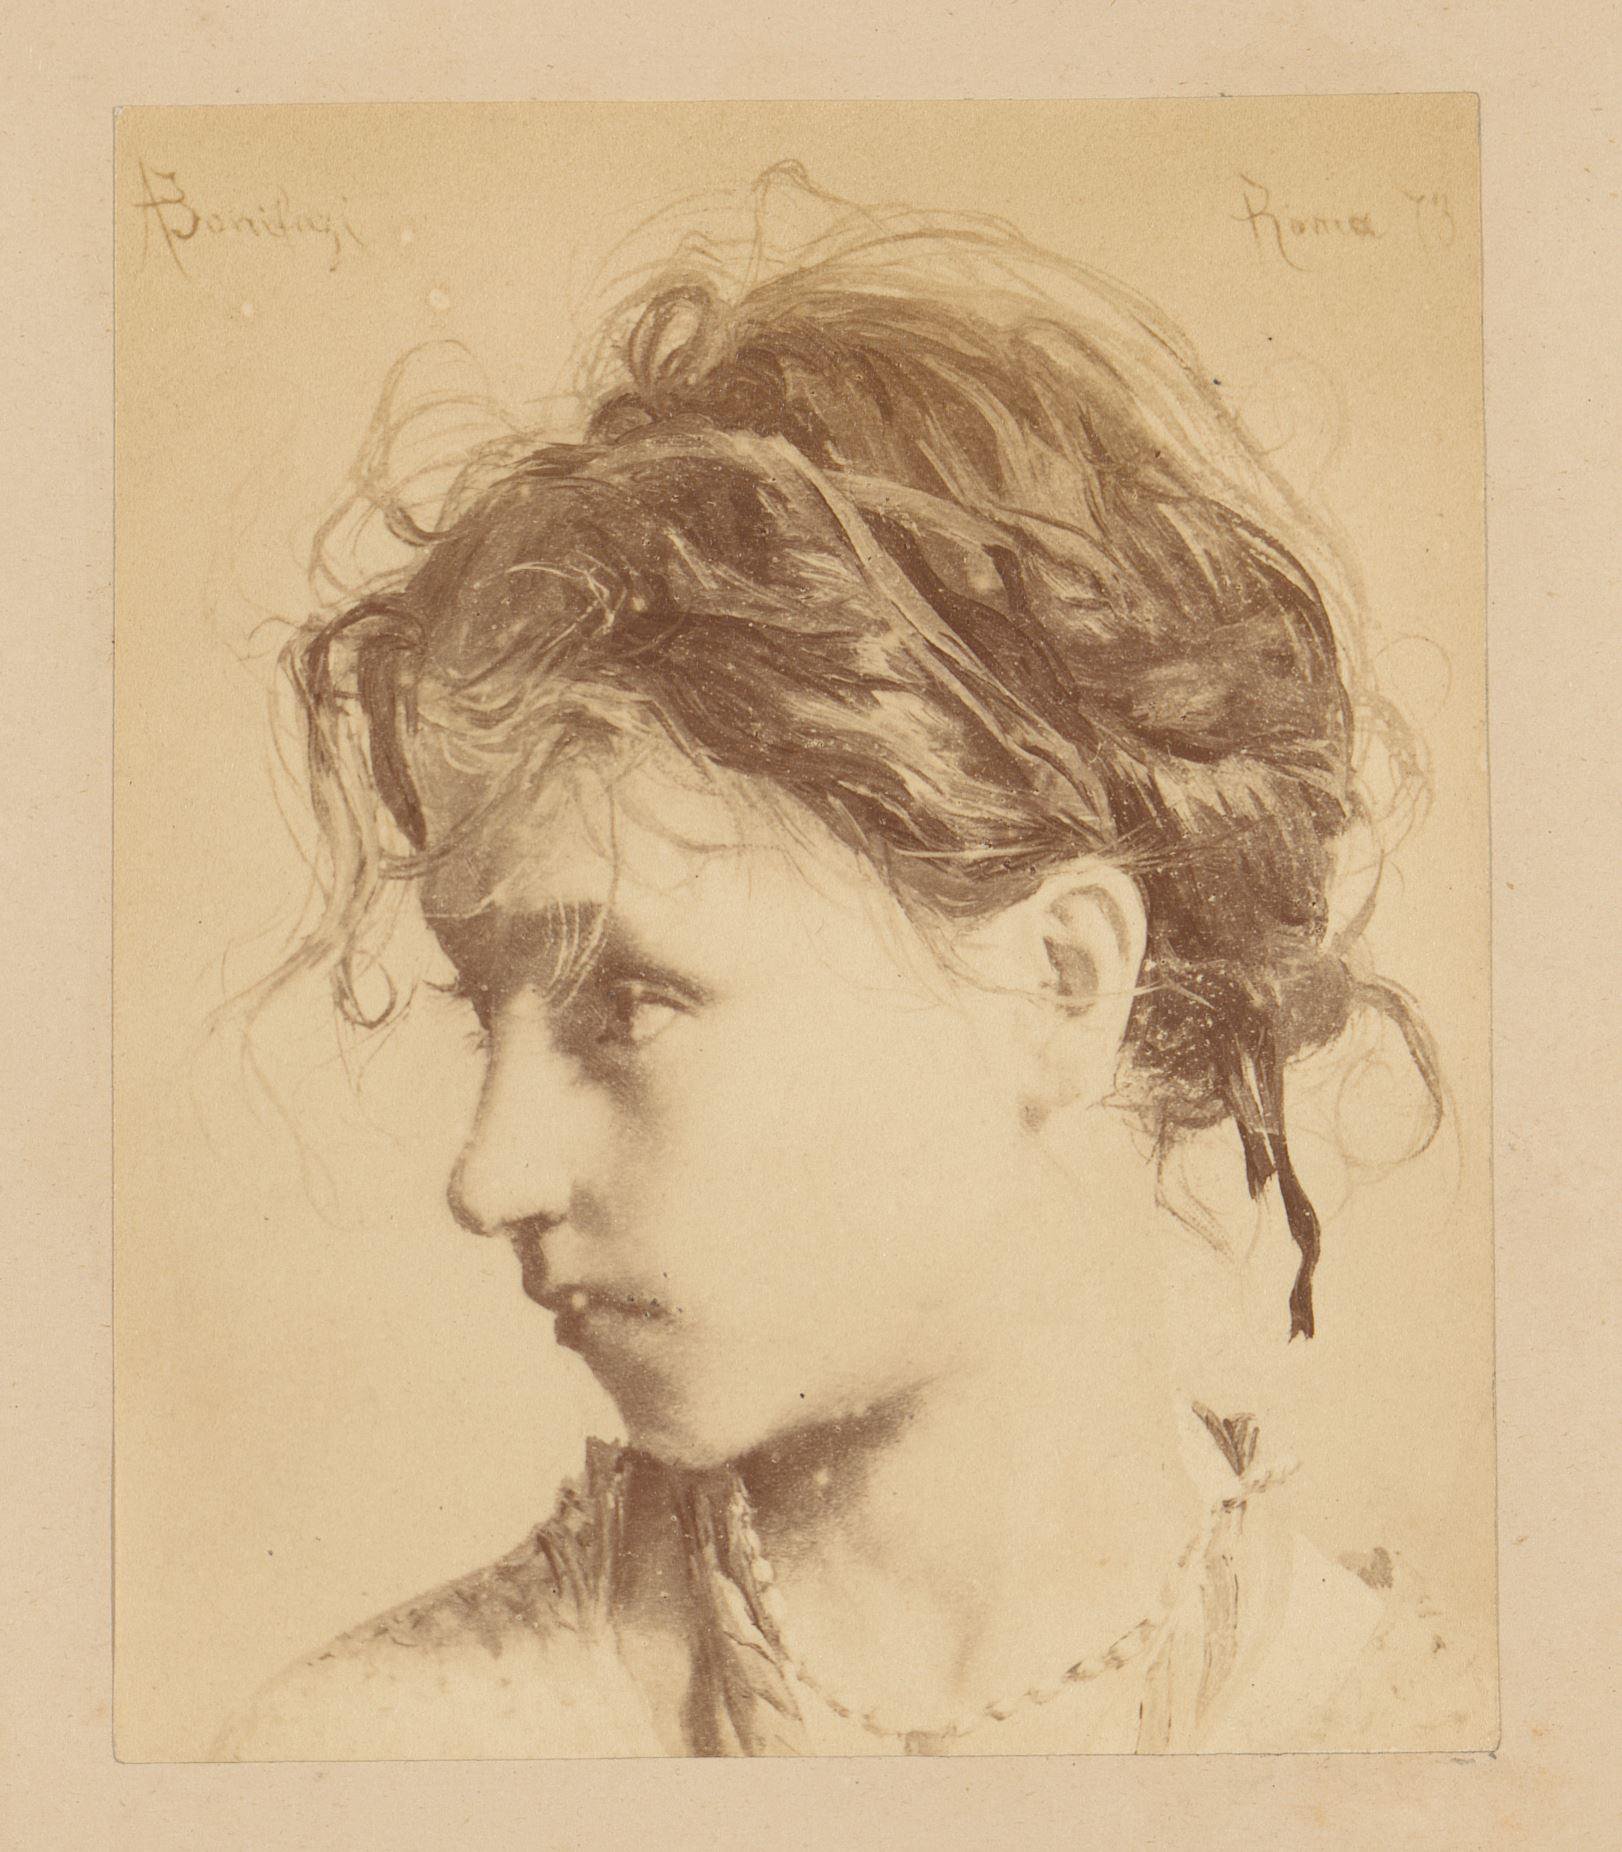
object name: album leaf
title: Schilderij met portret van een zigeunermeisje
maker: Anonymous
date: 1875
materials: photographic support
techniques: albumen print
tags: wandering communities: romani or roma, girl (child between toddler and youth)